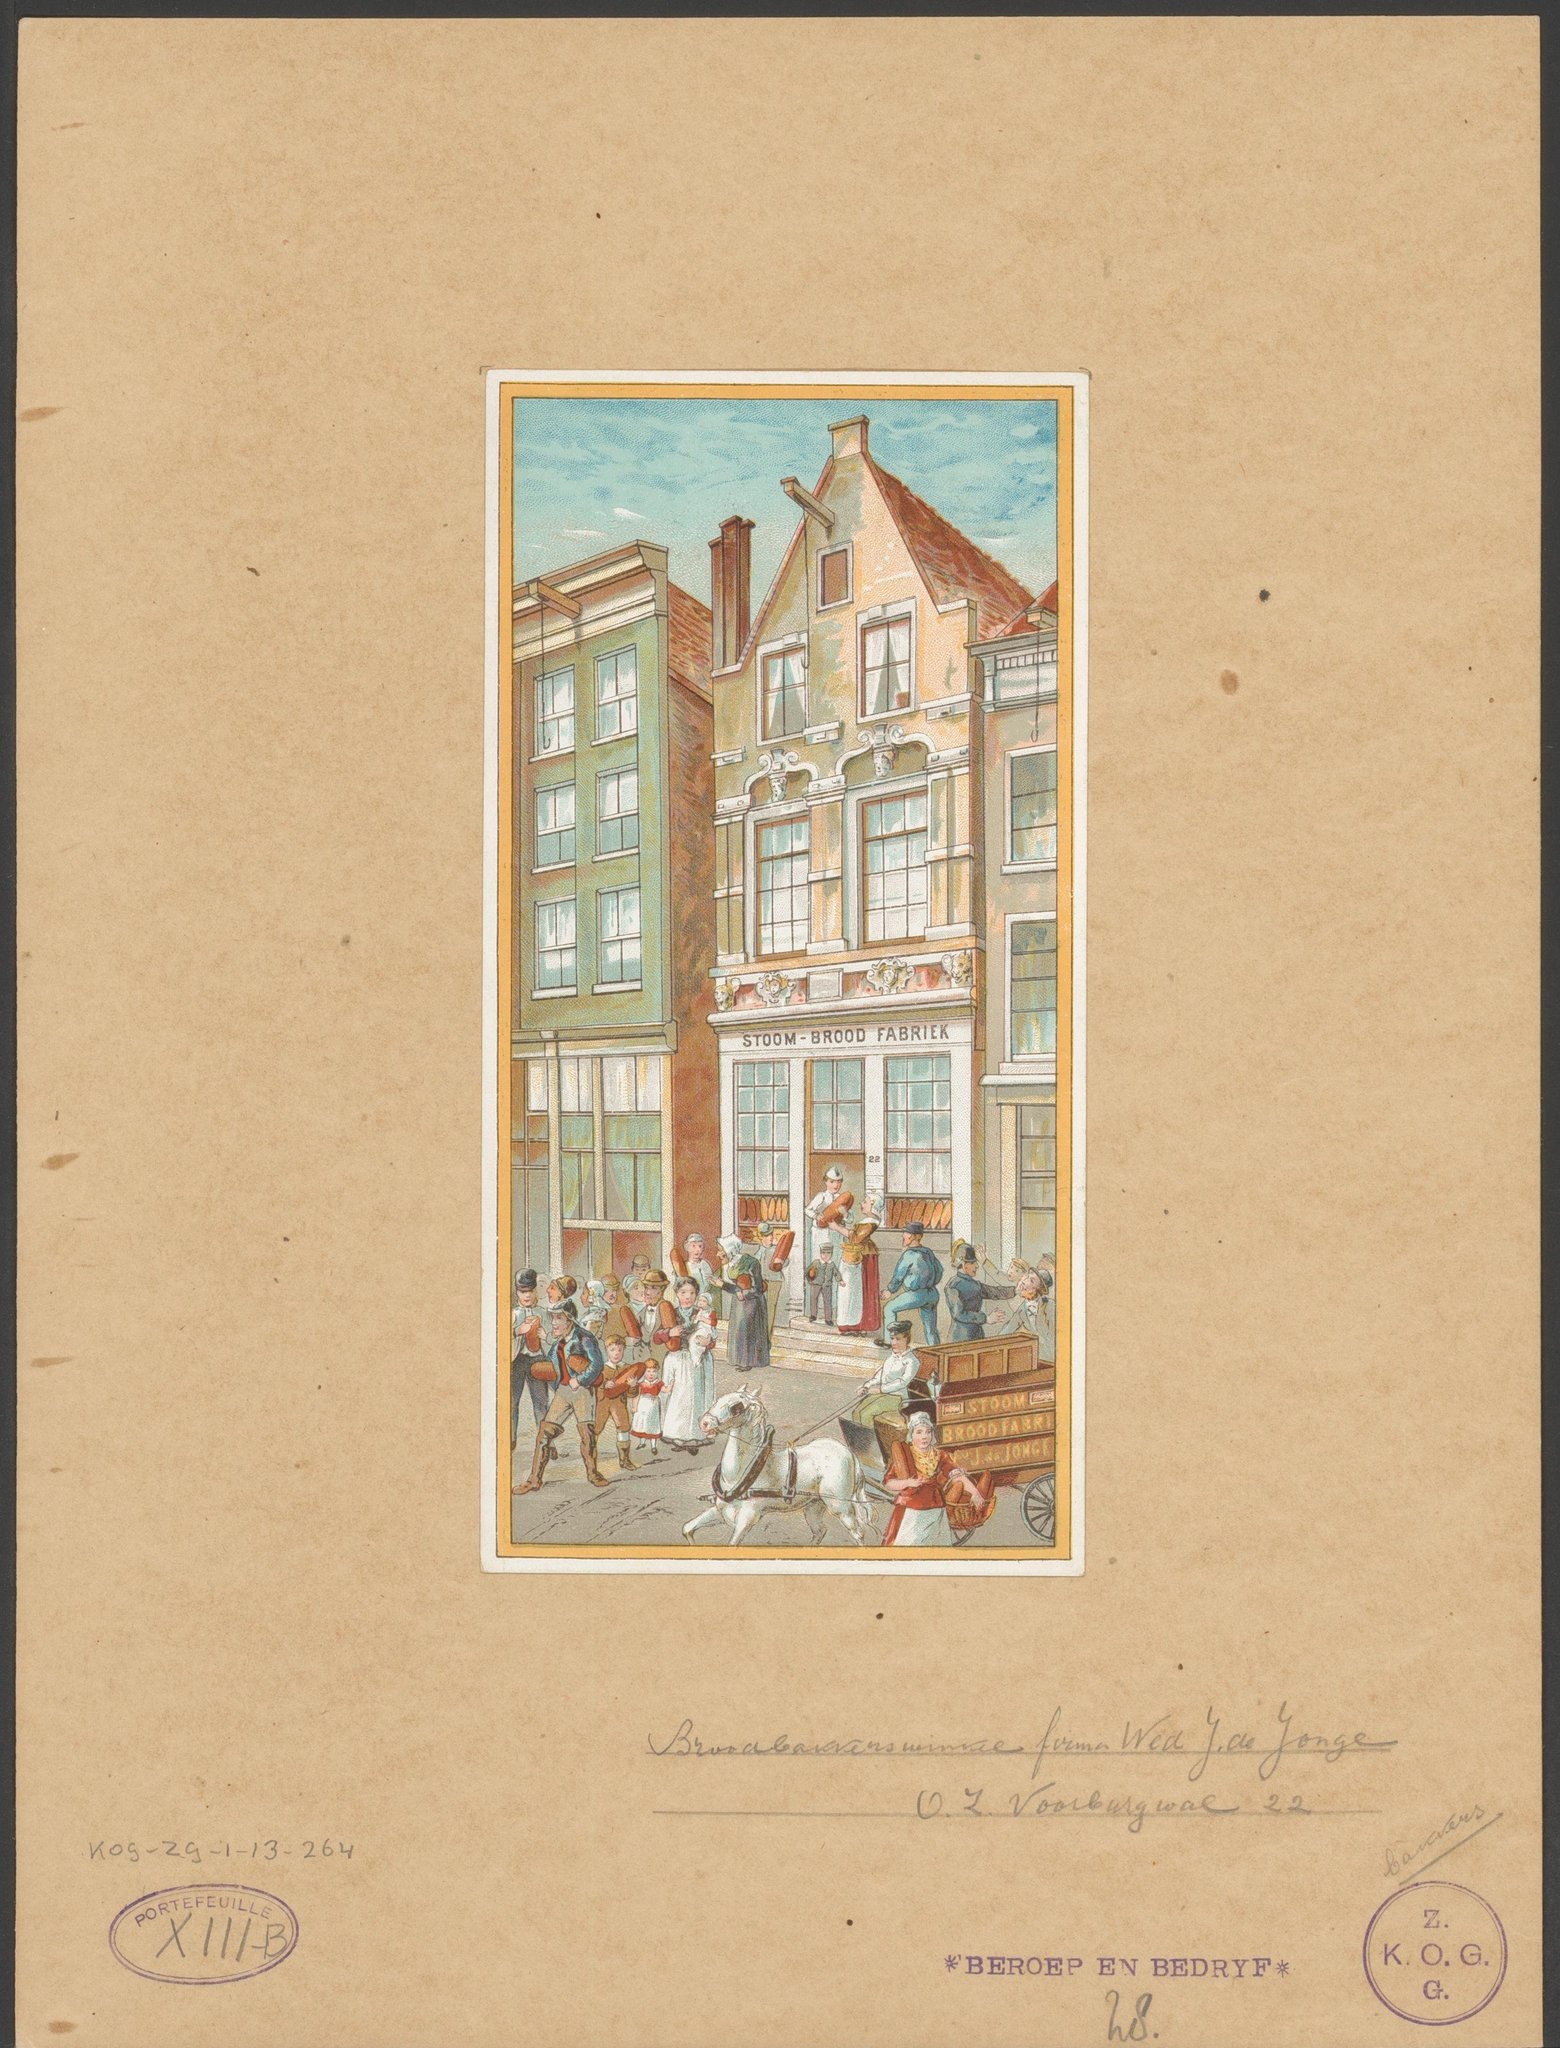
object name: photomechanical print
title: Stoombroodfabriek van de firma Wed. J. de Jonge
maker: Anonymous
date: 1850-1899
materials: paper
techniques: letterpress printing, printing block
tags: baker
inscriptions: stamp, collector's mark: Lugt 1641, stamp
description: Stoombroodfabriek van de firma Wed. J. de Jonge op de Oudezijds Voorburgwal. Broden werden gebakken op deze locatie en verkocht deze in verschillende verkooplokalen in Amsterdam. Onderwerpsrubrieken binnen de Atlas Zeden en Gewoonten: Handel, Nijverheid en Verkeer, Beroep en bedrijf, Mannelijk, Eet- en drinkwaren.